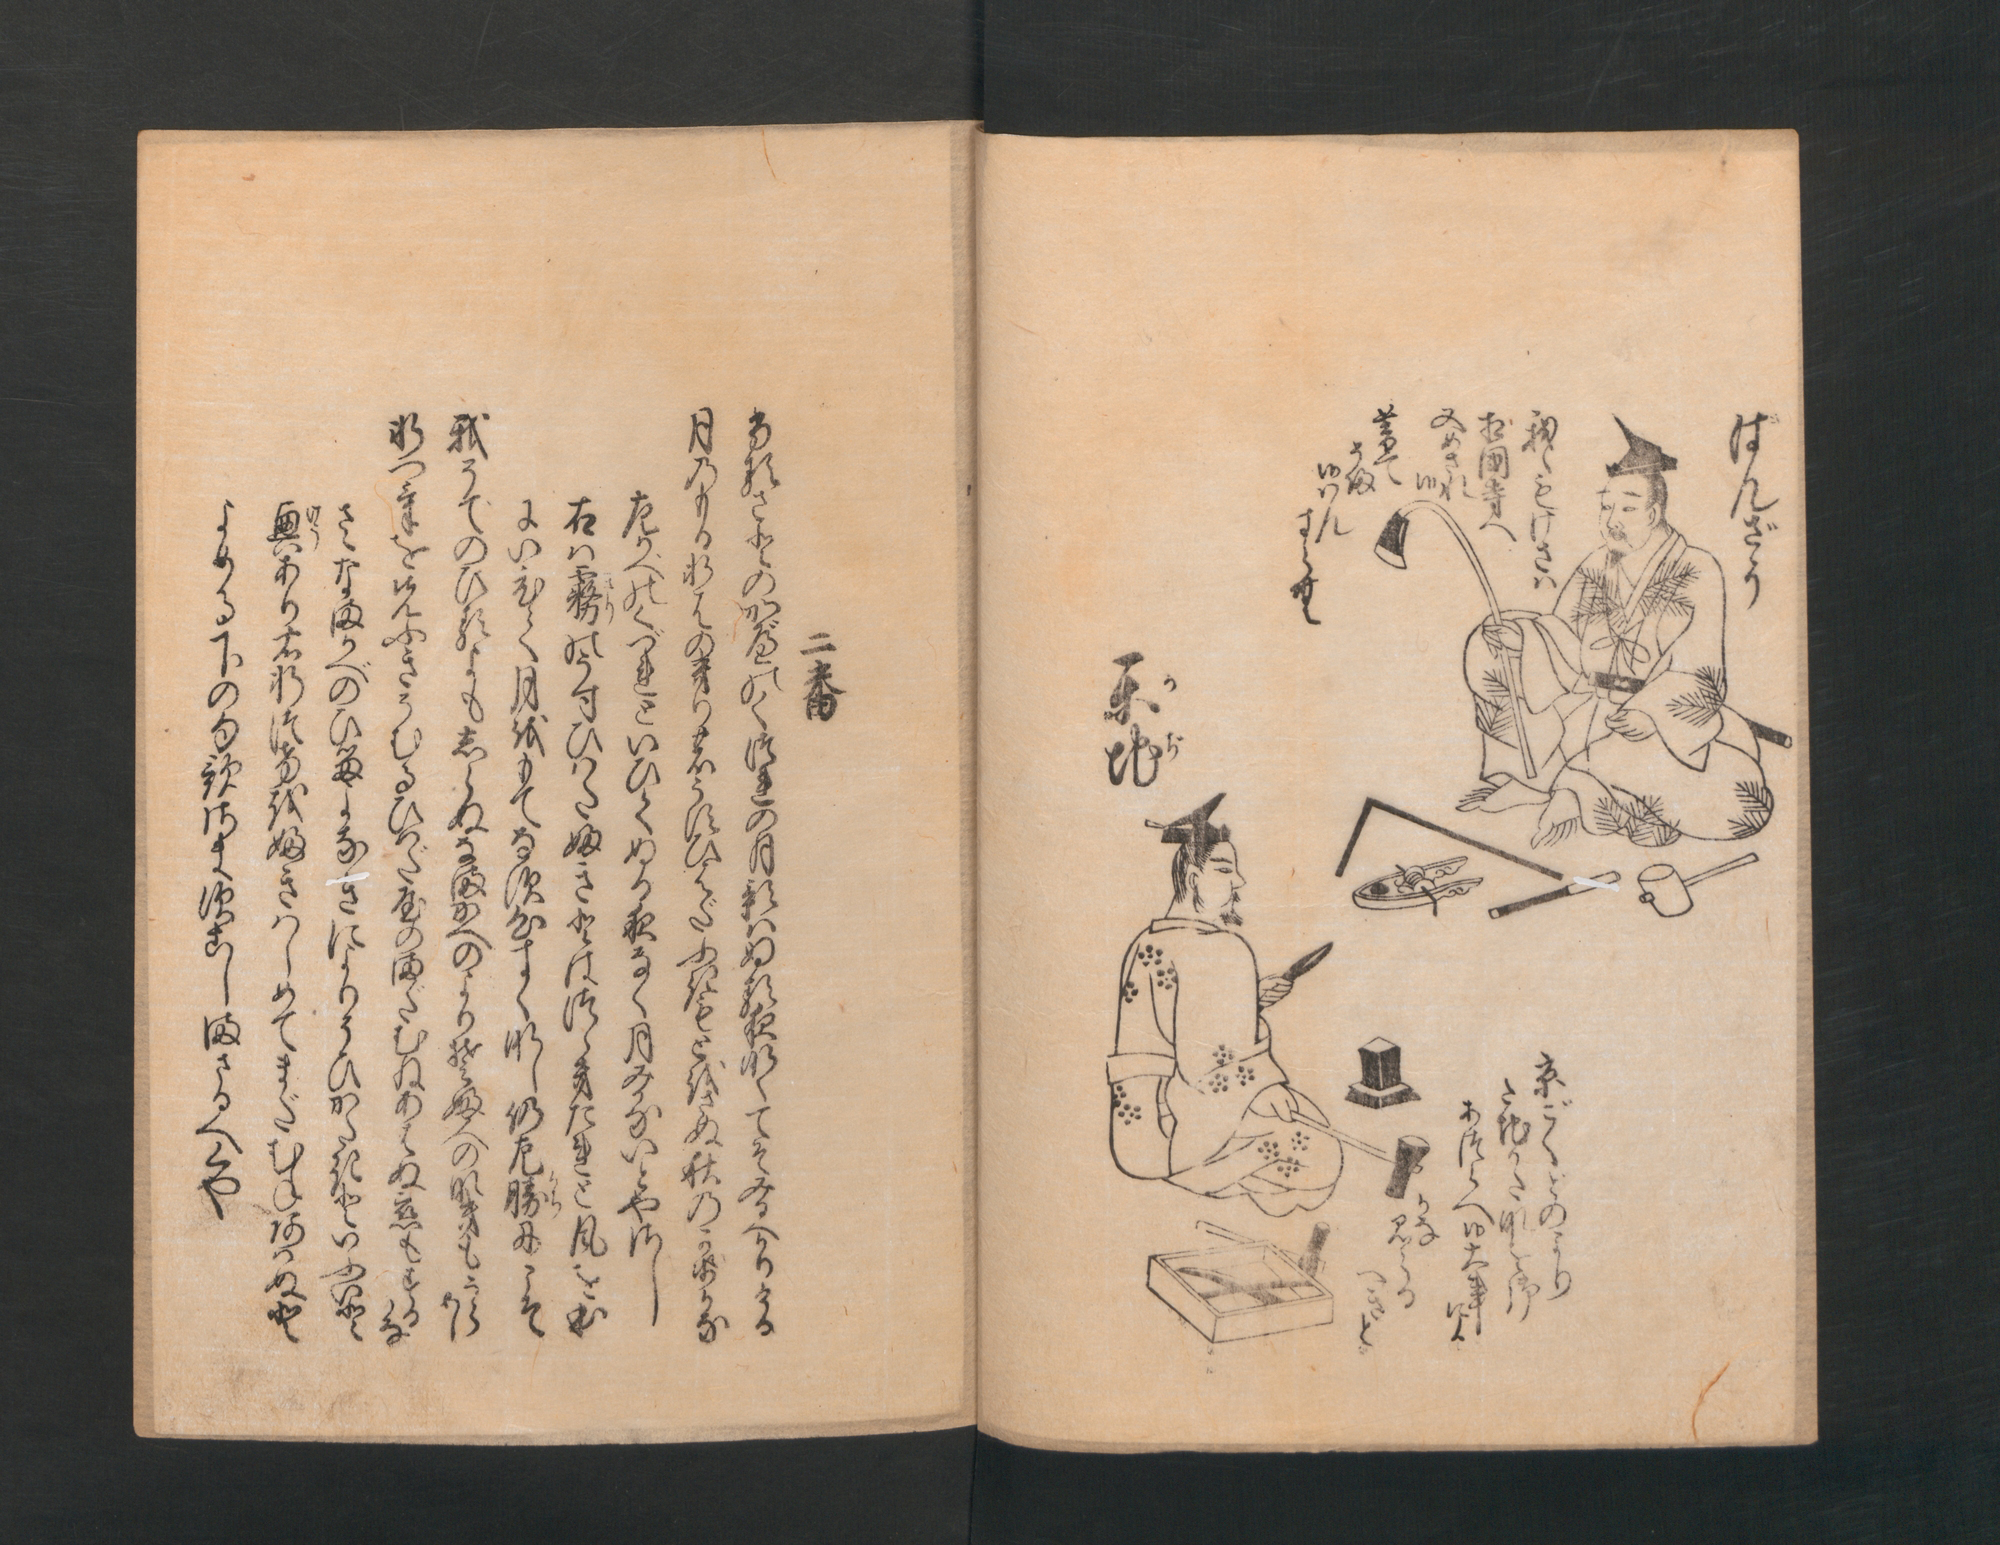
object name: illustrated book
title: Poetry Contest by Various Artisans (Shokunin zukushi uta-awase) 職人盡歌合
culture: japanese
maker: tosa, mitsunobu 土佐光信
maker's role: artist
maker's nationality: japanese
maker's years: 1462-1525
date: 1744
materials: ink, paper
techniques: woodblock print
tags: poetry,men